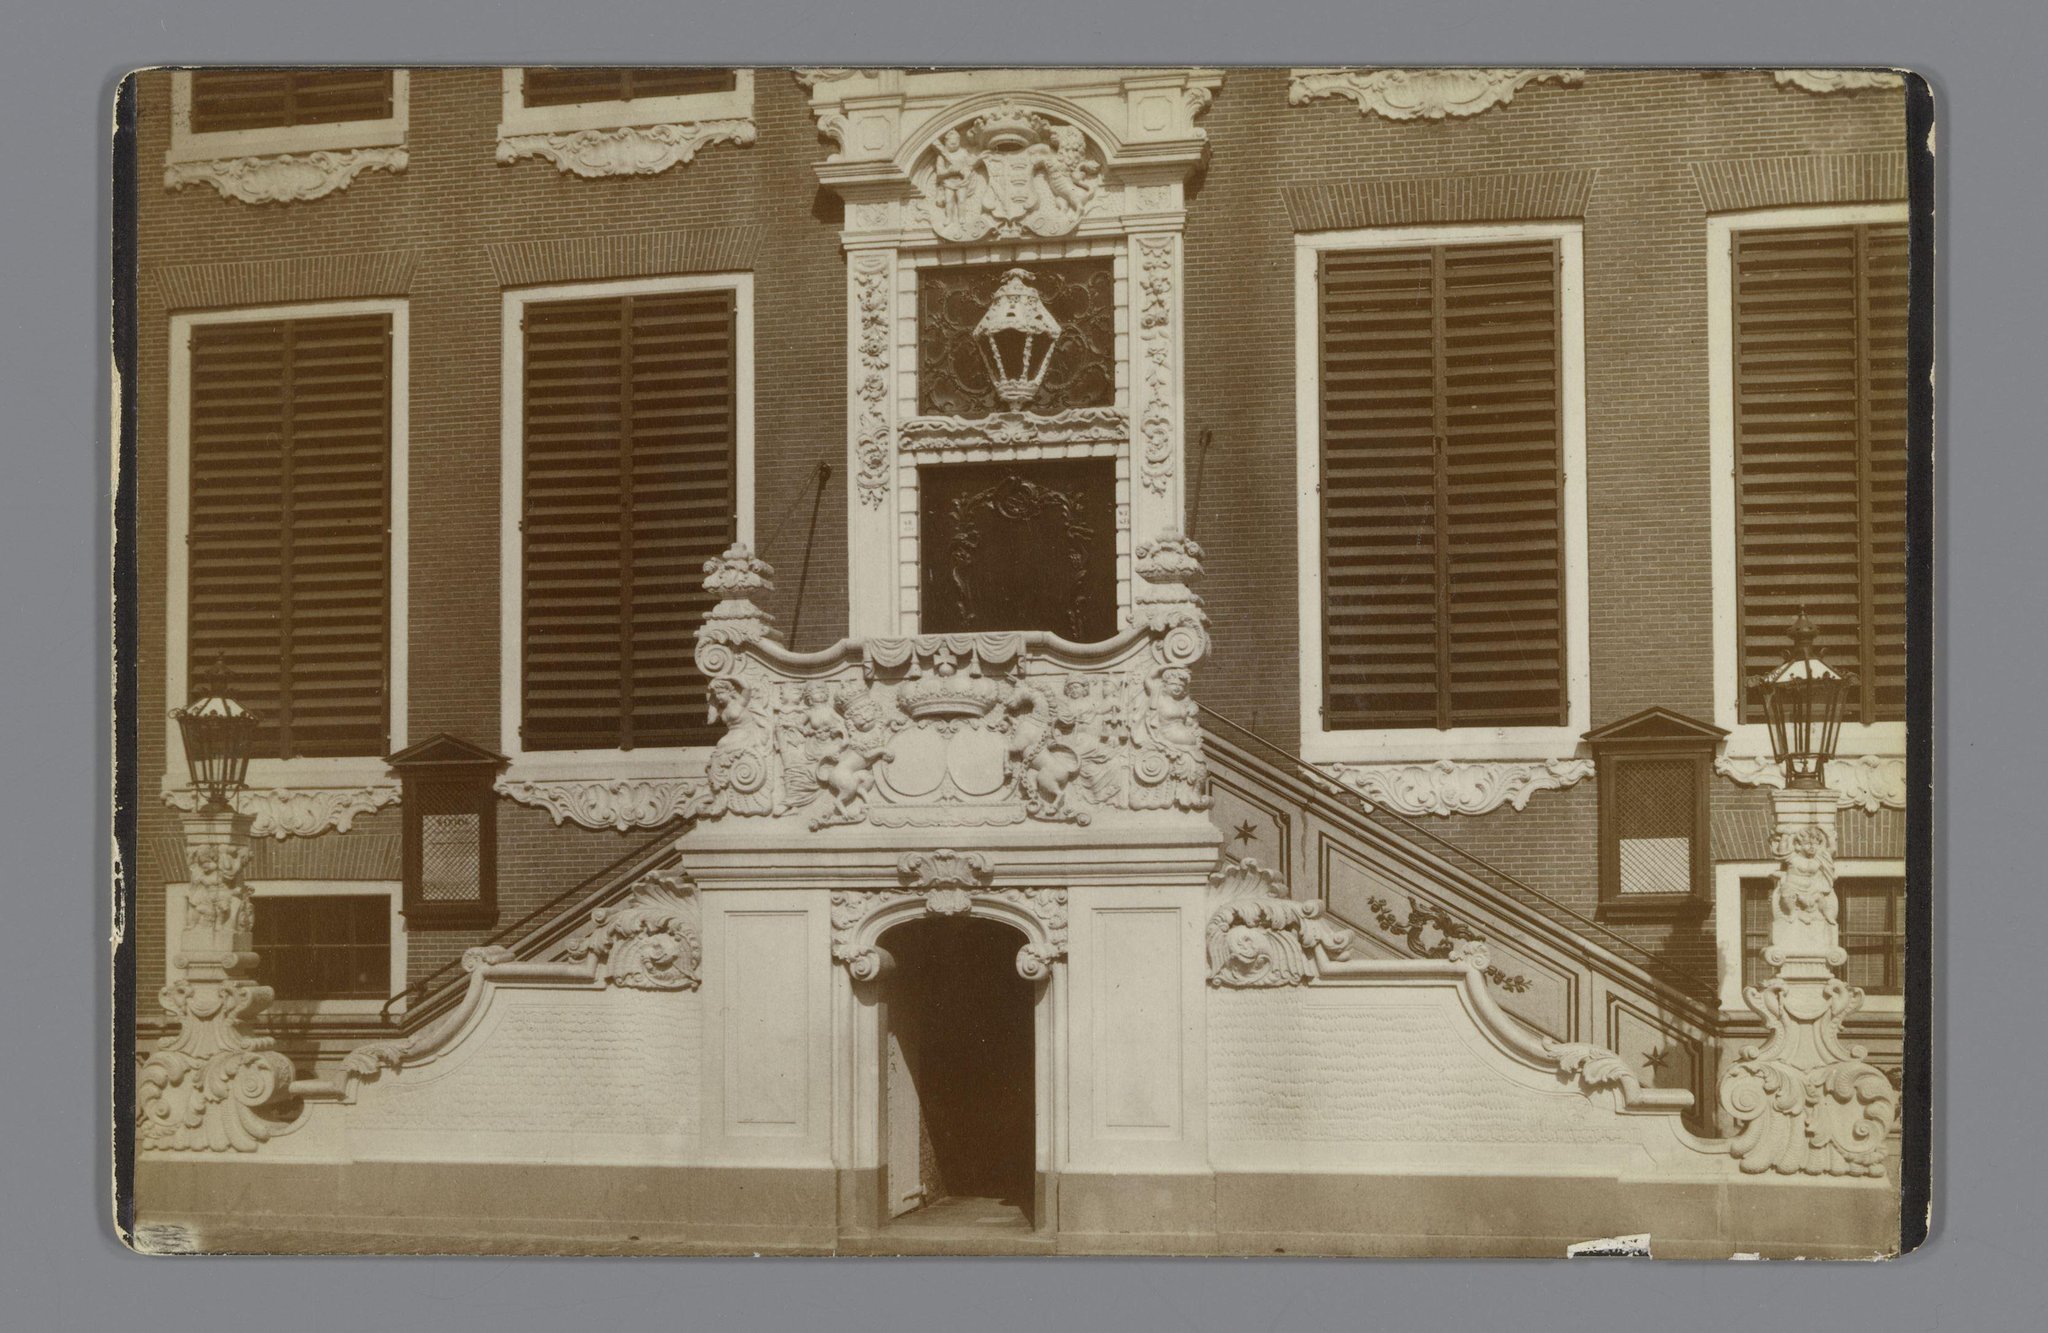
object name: cabinet photograph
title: Bordes van het stadhuis van Sneek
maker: albert dekema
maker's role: publisher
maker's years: 1824-1909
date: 1865-1896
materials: cardboard, photographic support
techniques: albumen print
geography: sneek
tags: townhall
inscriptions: inscription: ‘A. DEKEMA ENKHUIZEN’, annotation: ‘Sneek’